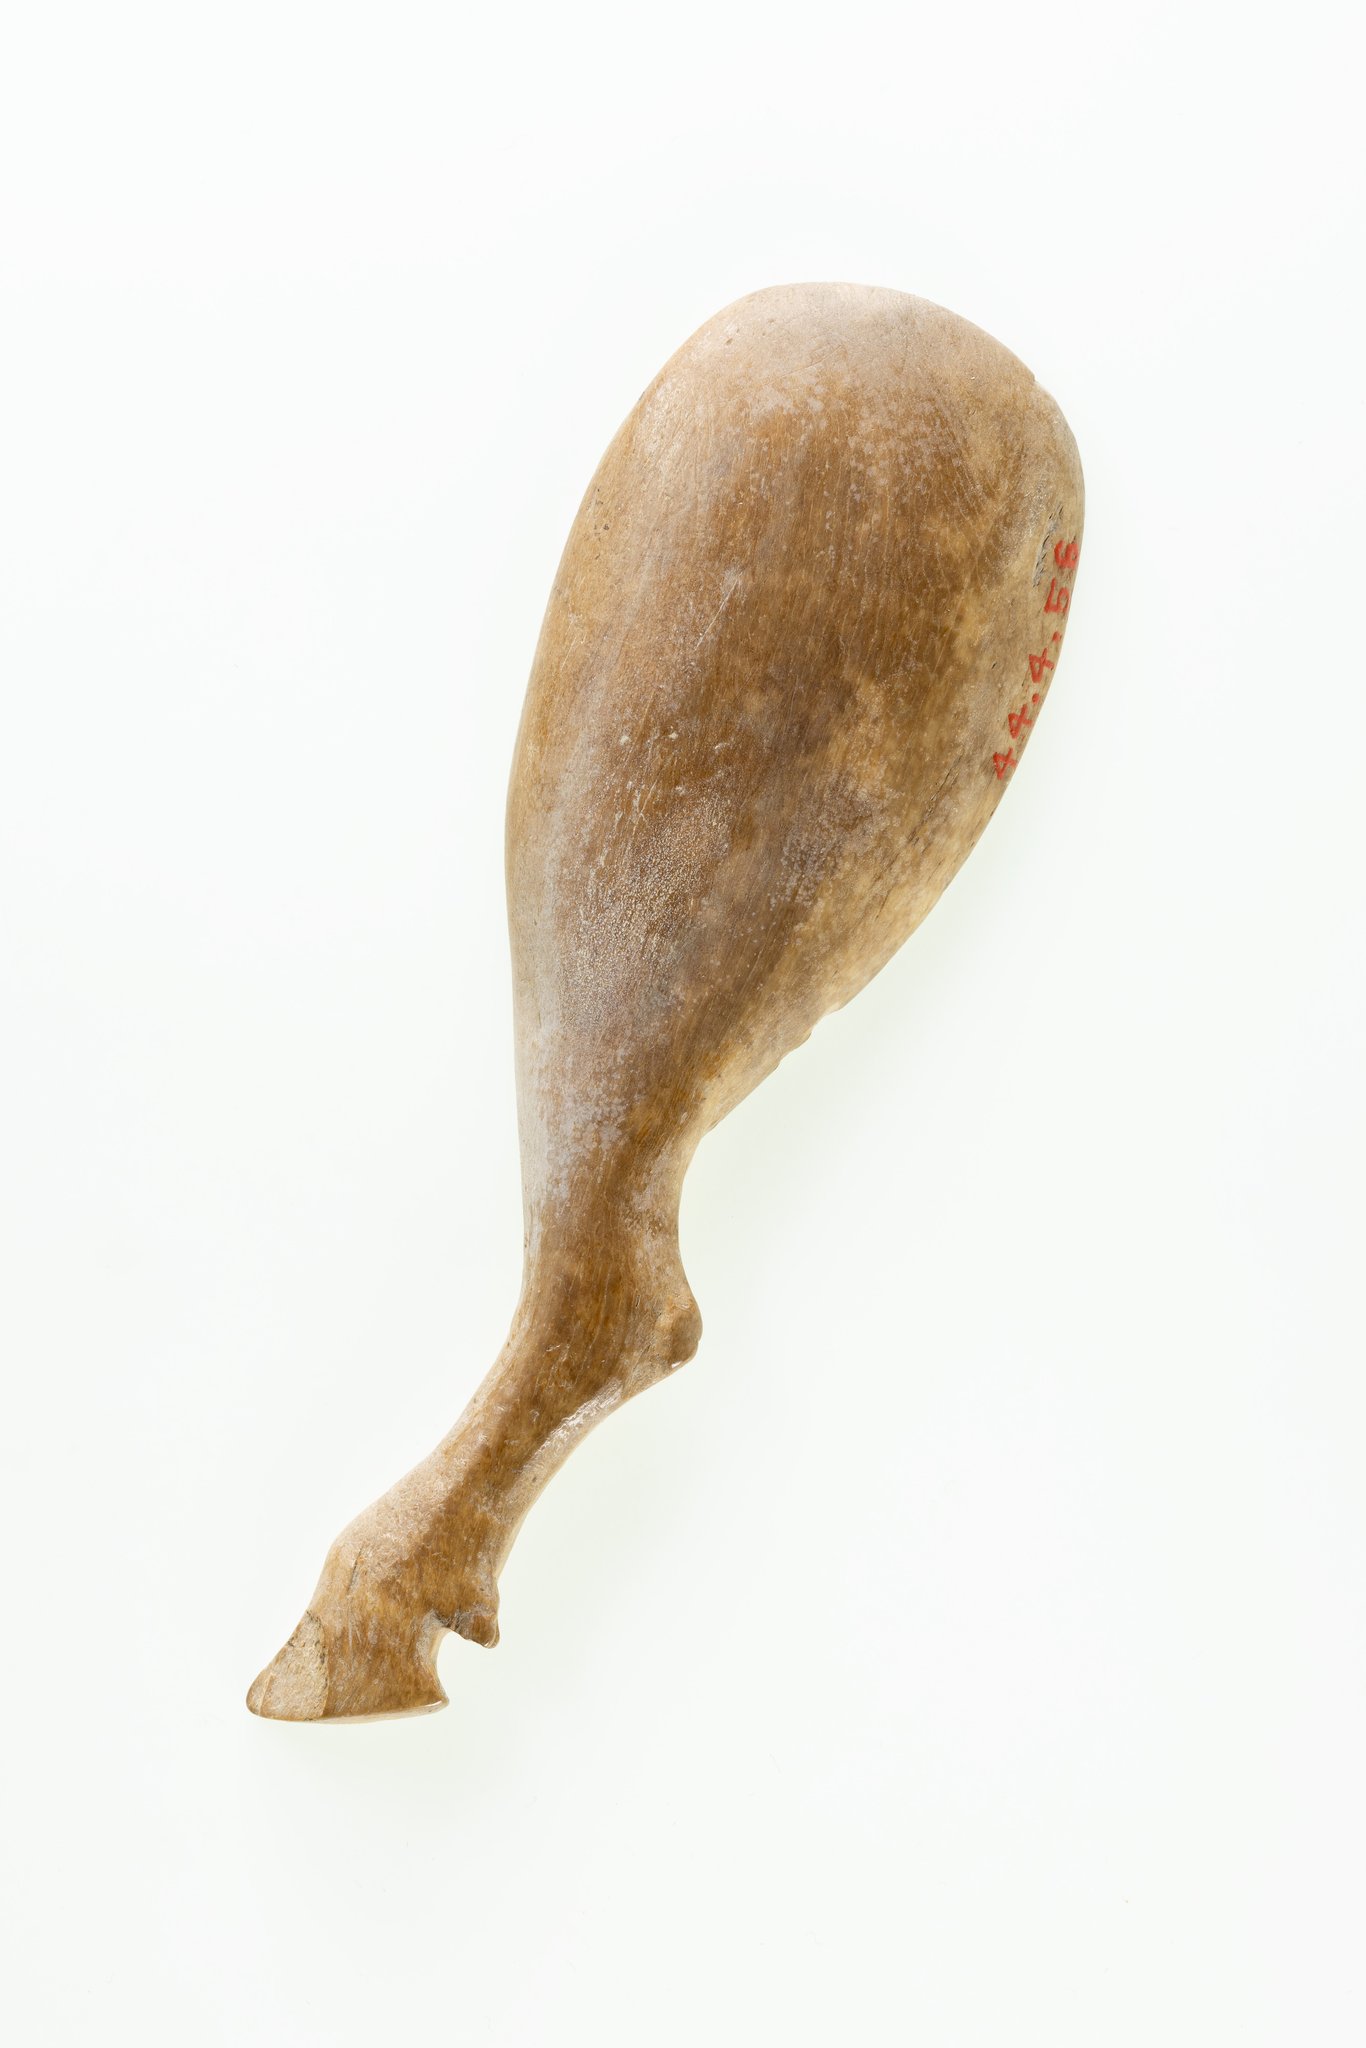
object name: dish, ox leg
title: Ox leg dish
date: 1550-1295 BCE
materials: ivory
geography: egypt